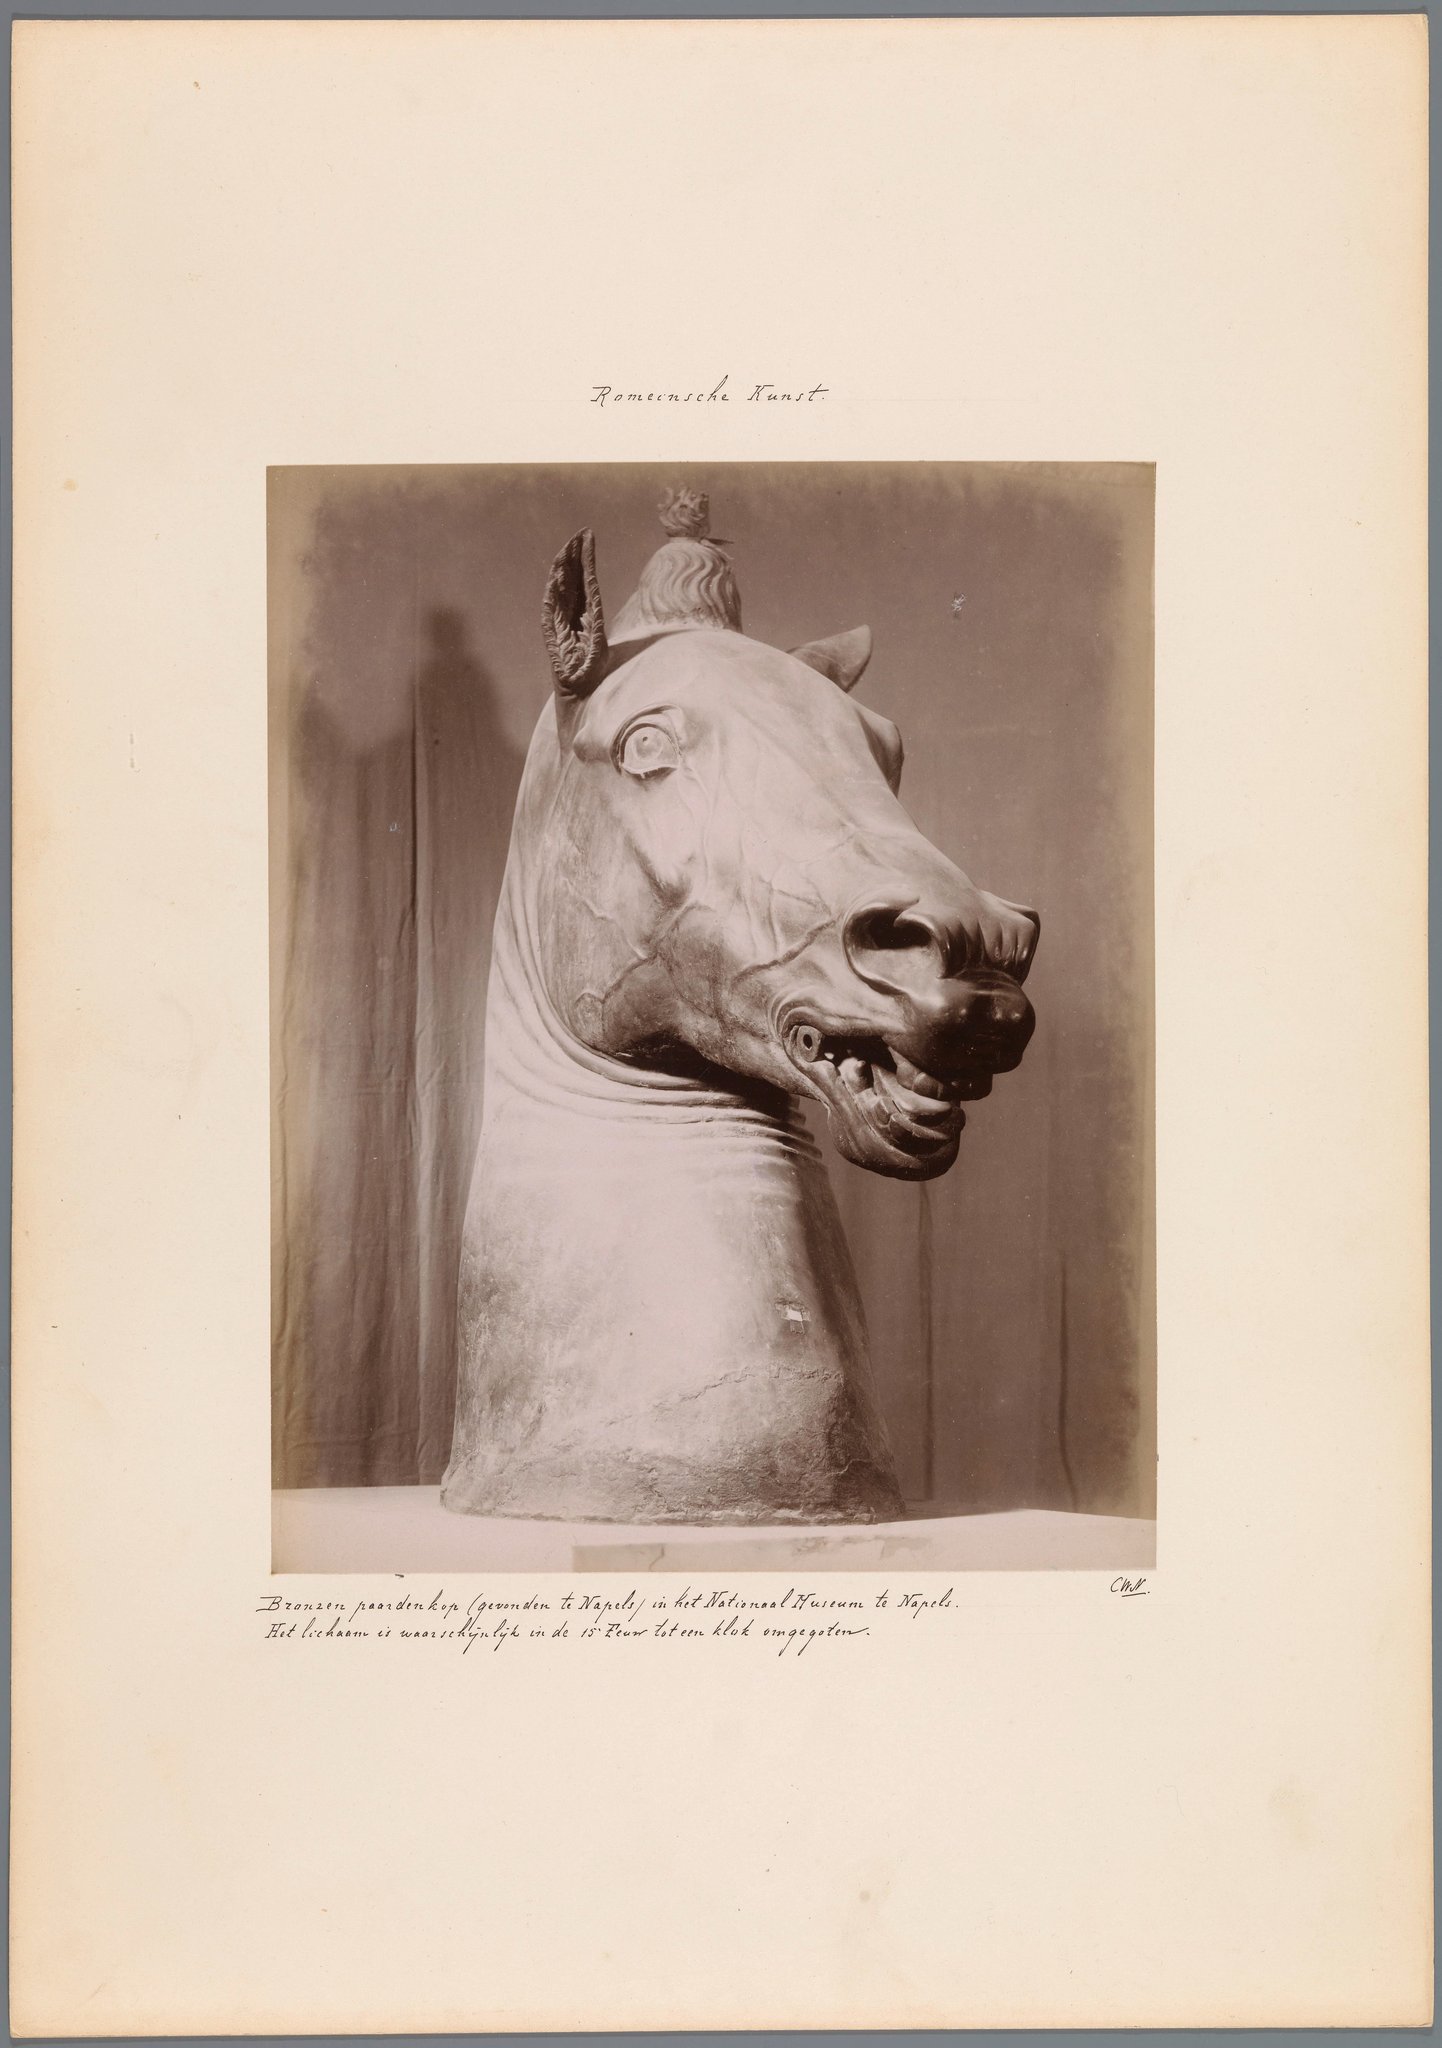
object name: photograph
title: Bronzen sculptuur van een paardenhoofd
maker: Anonymous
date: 1875-1900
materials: cardboard, photographic support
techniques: albumen print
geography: europe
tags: piece of sculpture, reproduction of a piece of sculpture, horse, europe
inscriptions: inscription: ‘Romeinsche Kunst.’, inscription: ‘CWN.’, collector's mark: ‘INSTITUUT VOOR KUNST-NIJVERHEIDSONDERWIJS GABRIËL METSUSTRAAT No. 16 AMSTERDAM’, collector's mark: ‘KUNSTNIJVERHEIDSCHOOL QUELLINUS AMSTERDAM FRANS HALSSTRAAT 14.’